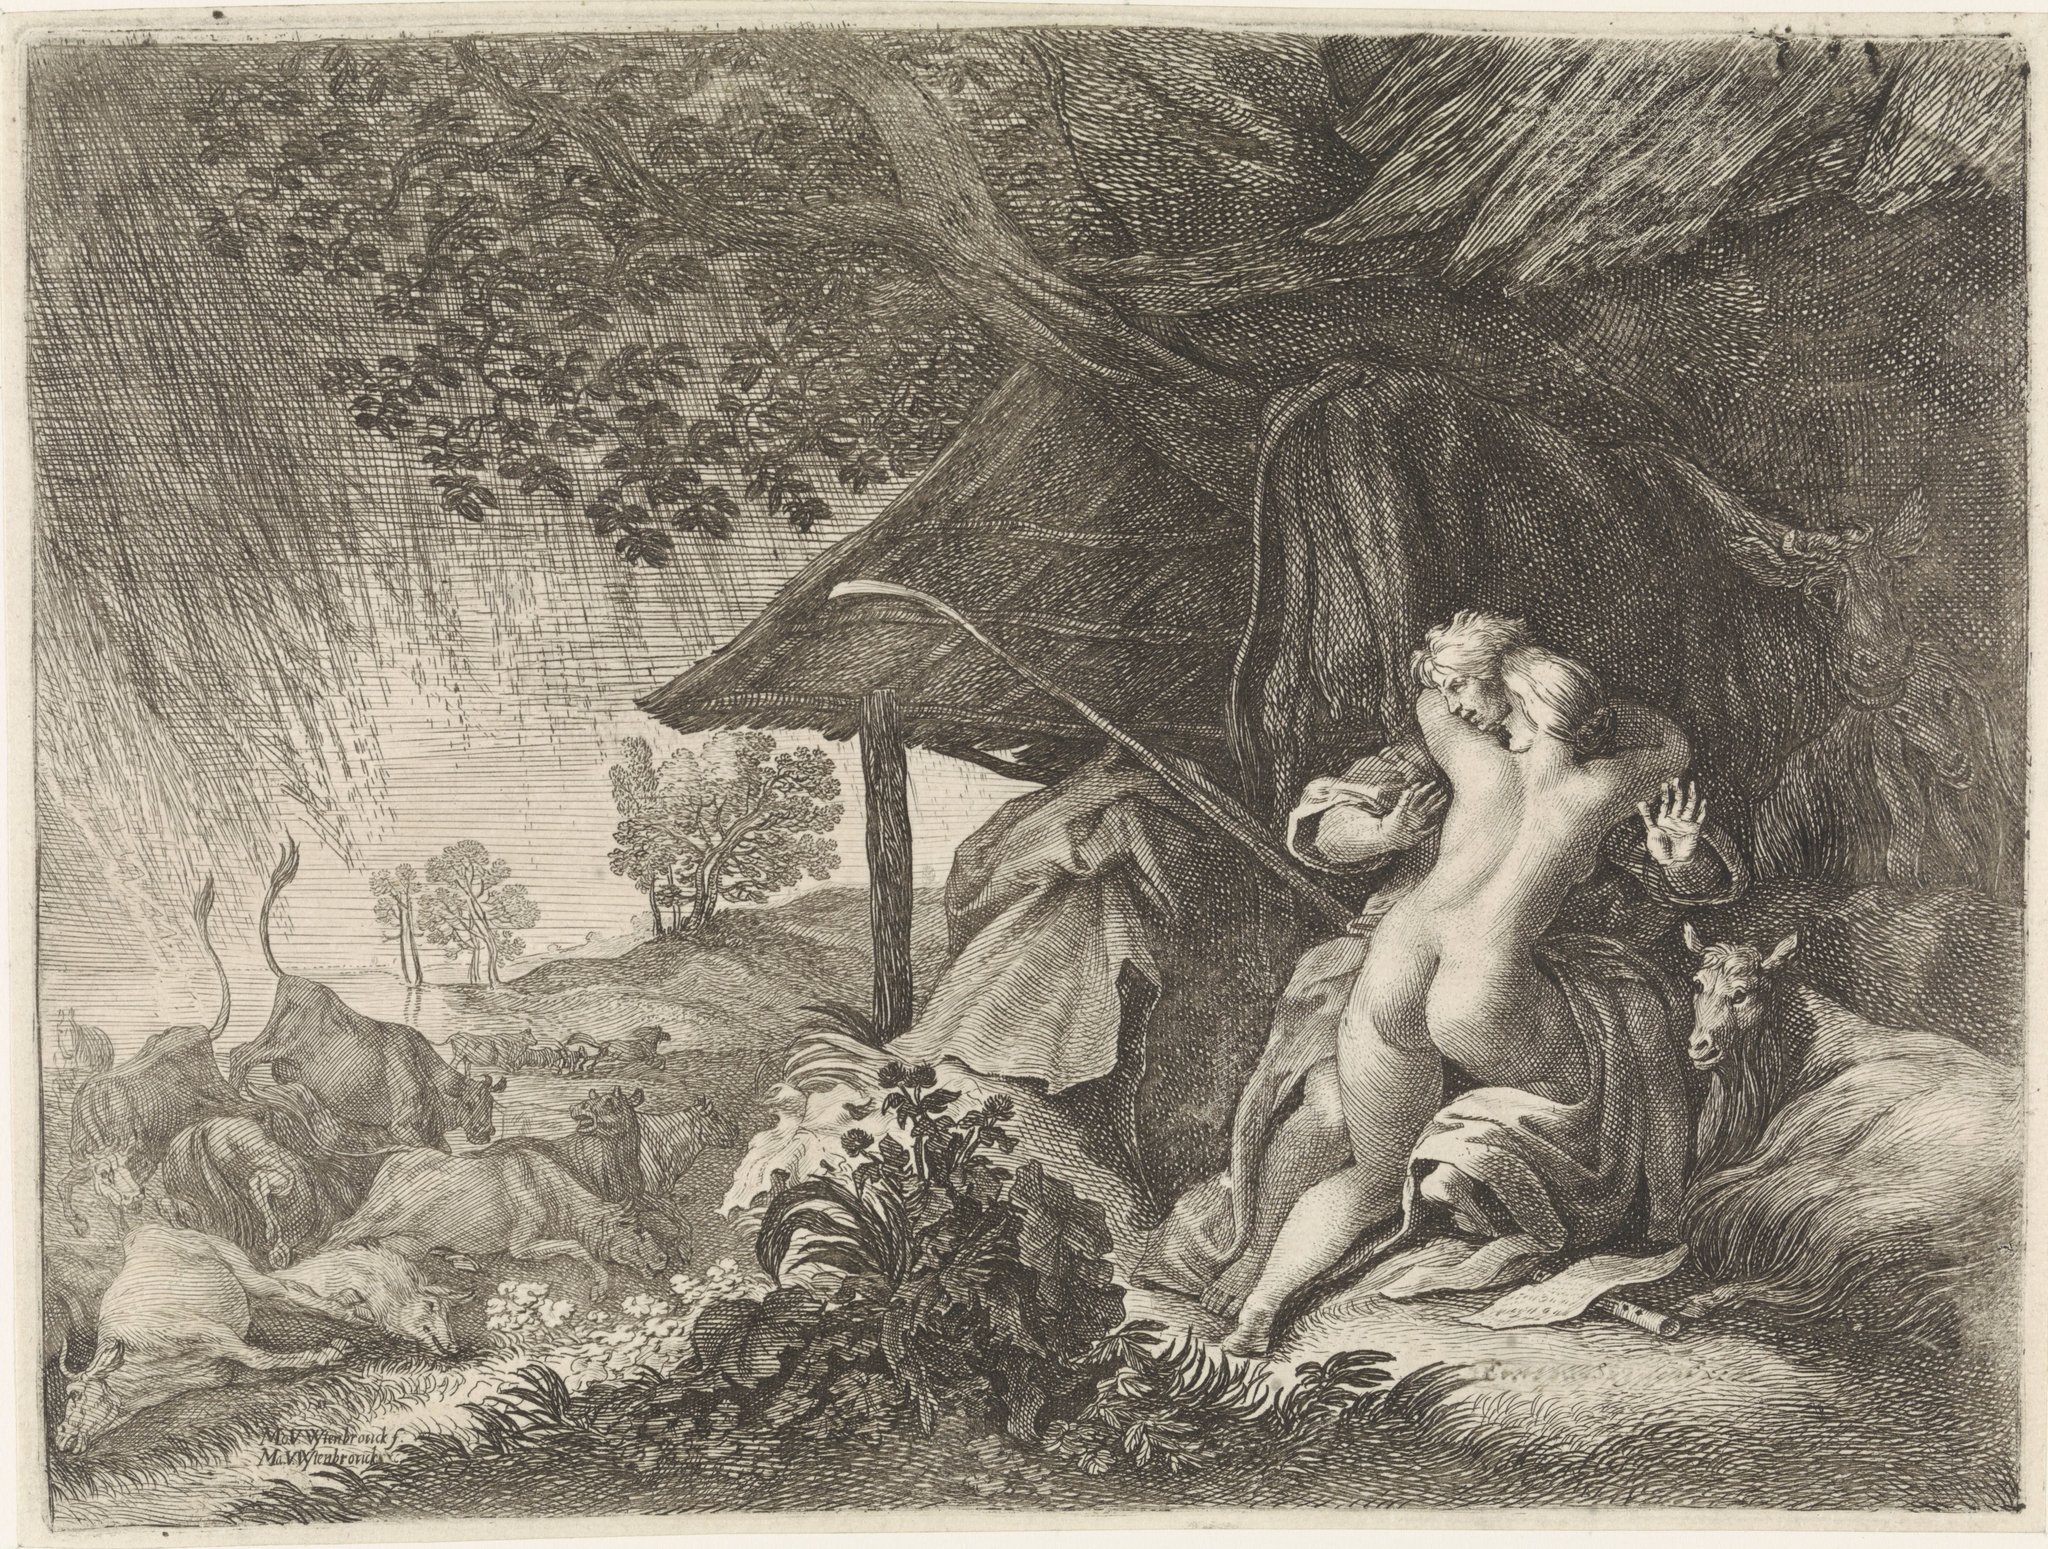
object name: print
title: Herder en herderin schuilend voor een storm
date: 1600-1647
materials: paper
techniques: engraving, etching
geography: the hague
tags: thunderstorm, pastorals, arcadian scenes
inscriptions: collector's mark: Lugt 2610, collector's mark: Lugt 2228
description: De herder en herderin schuilen onder een afdak in elkaars armen voor een hevige storm. Op de grond een fluit en bladmuziek. Een kudde koeien, over elkaar heen vallend, vlucht in paniek.